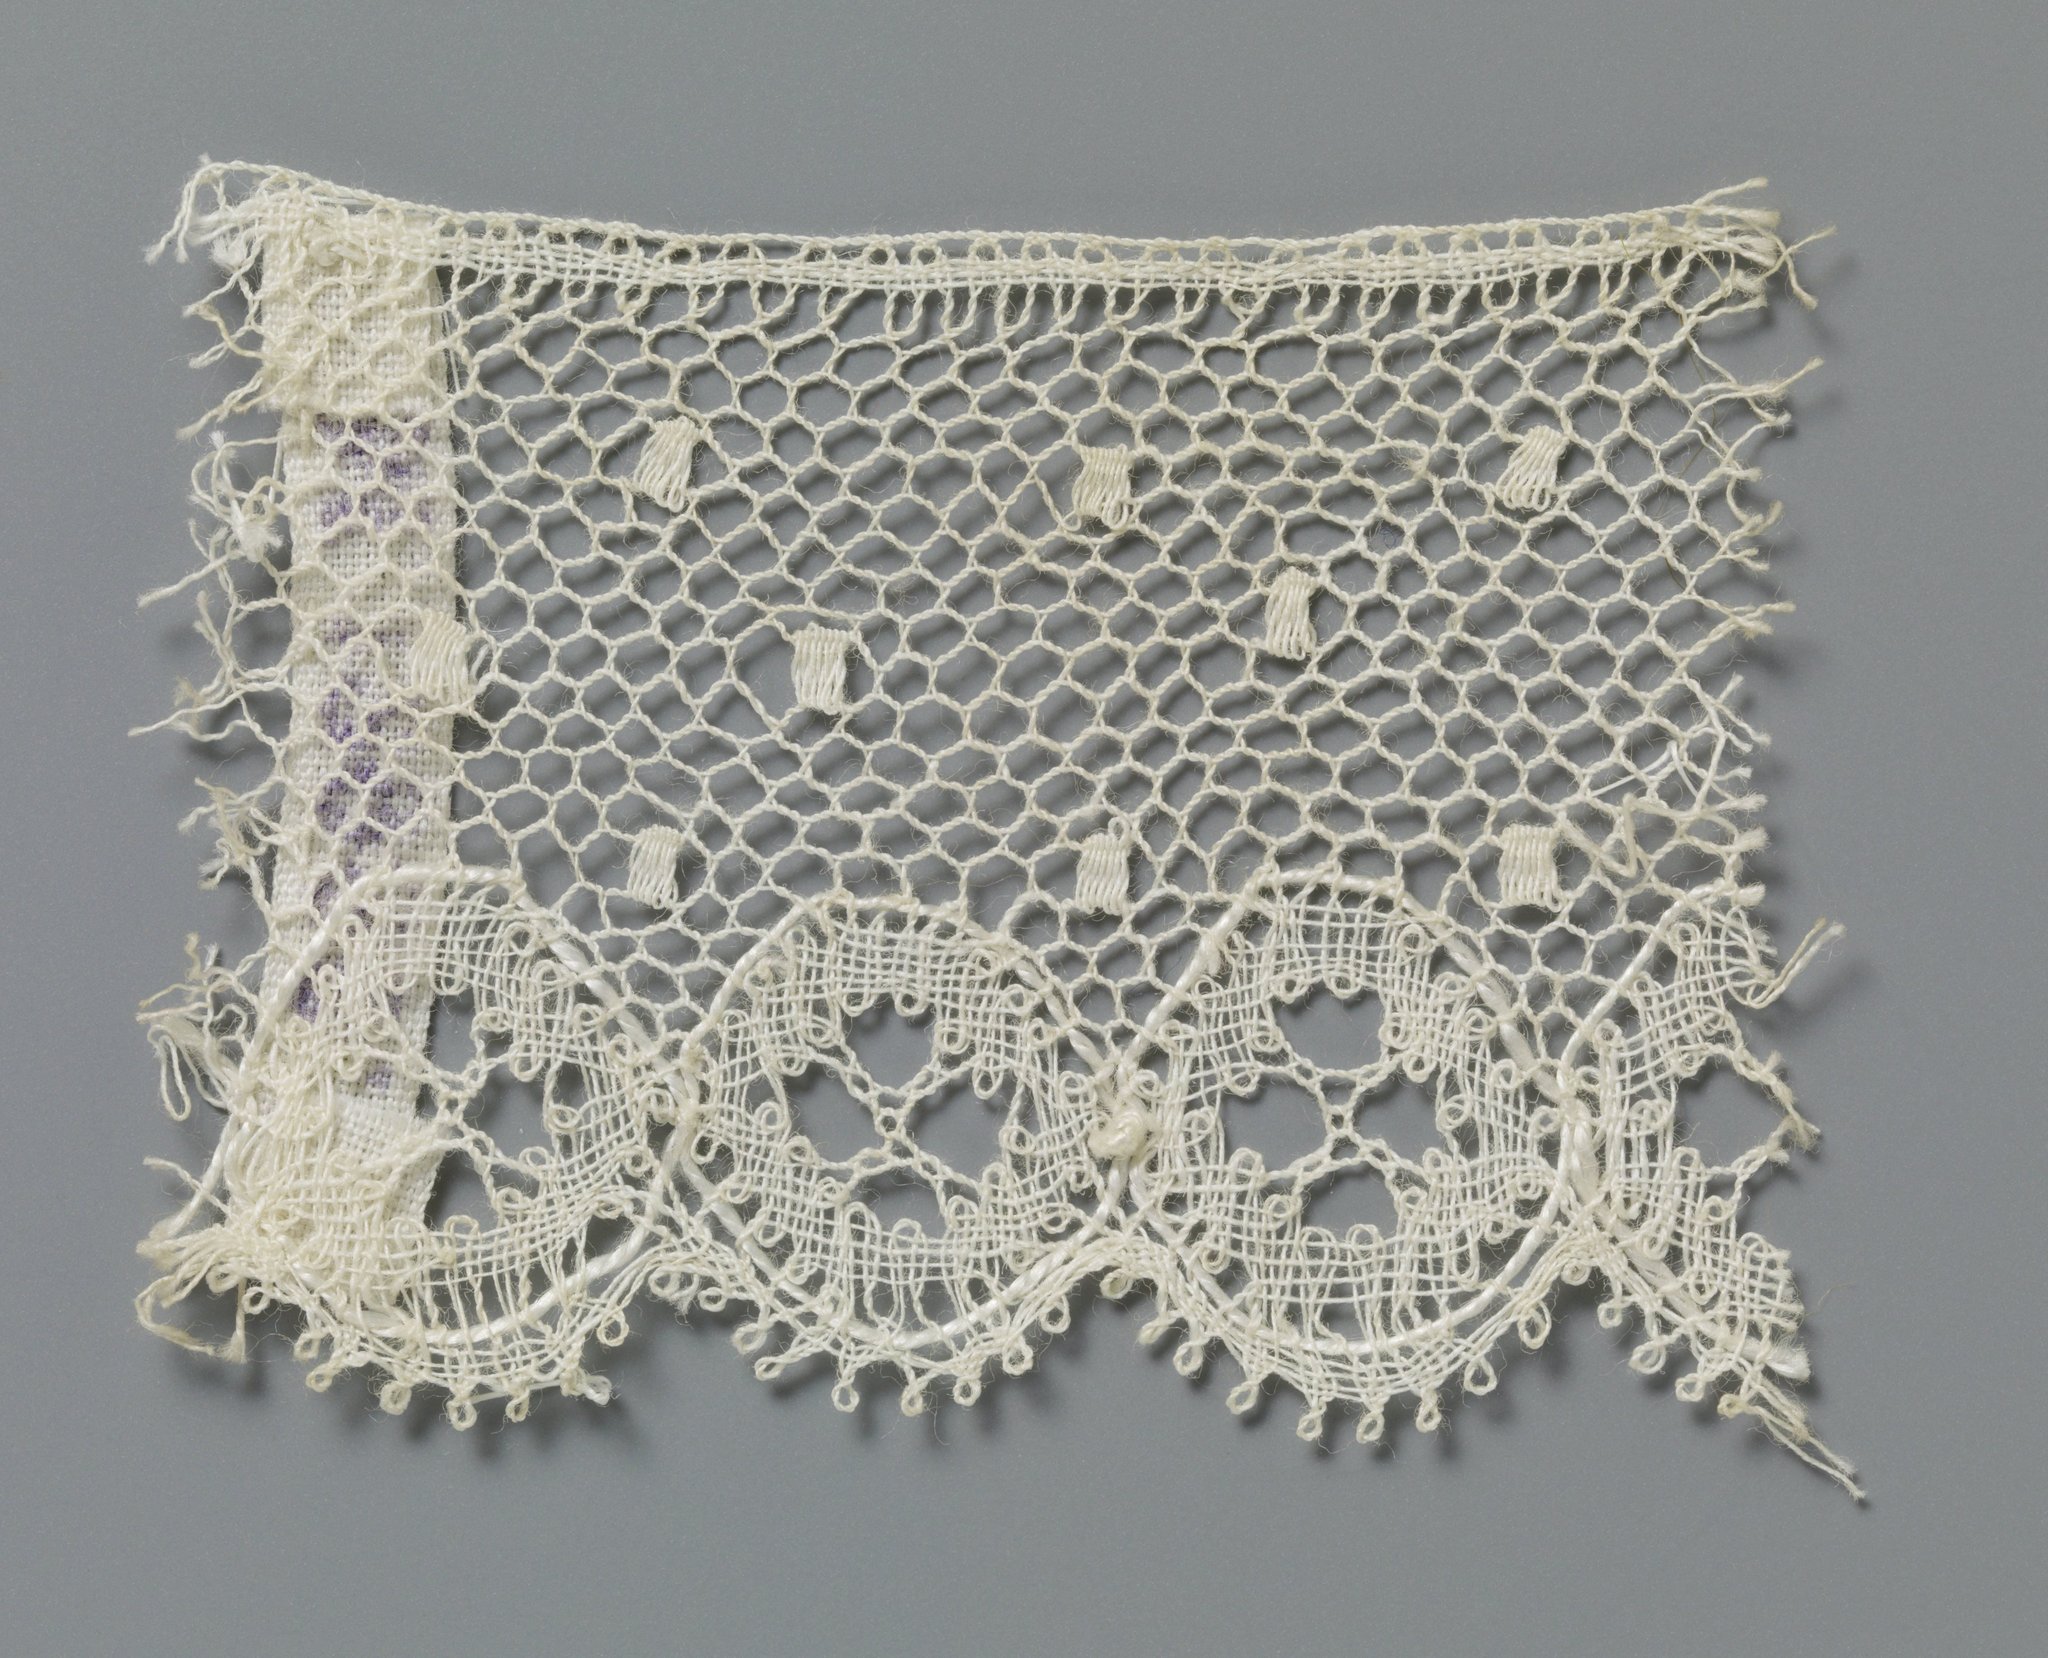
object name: strip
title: Strook kloskant met aaneengeschakelde cirkels langs de onderzijde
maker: Anonymous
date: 1800-1899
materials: cotton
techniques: lace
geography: buckingham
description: Strook naturelkleurige kloskant, Buckingham-kant. Onder een strooipatroon van vierkante moesjes bestaat het zich herhalende patroon uit aaneengeschakelde cirkels met een opengewerkt centrum. De motieven zijn aan de bovenkant met elkaar verbonden door een maasgrond, een tulegrond. De cirkels zijn gemaakt in linnenslag met een opengewerkt centrum. Alleen de buitenkant van elke cirkel is geaccentueerd met dikke en glimmende contourdraden, het centrum is niet met contourdraden geaccentueerd. In het centrum van elke cirkel is beperkt een siergrond toegepast, je ziet een deel van de tralie van een rozengrond. De bovenzijde van de strook is recht afgewerkt. De schulpenrand langs de onderzijde komt voort uit het patroon met de cirkels en is afgewerkt met picots.